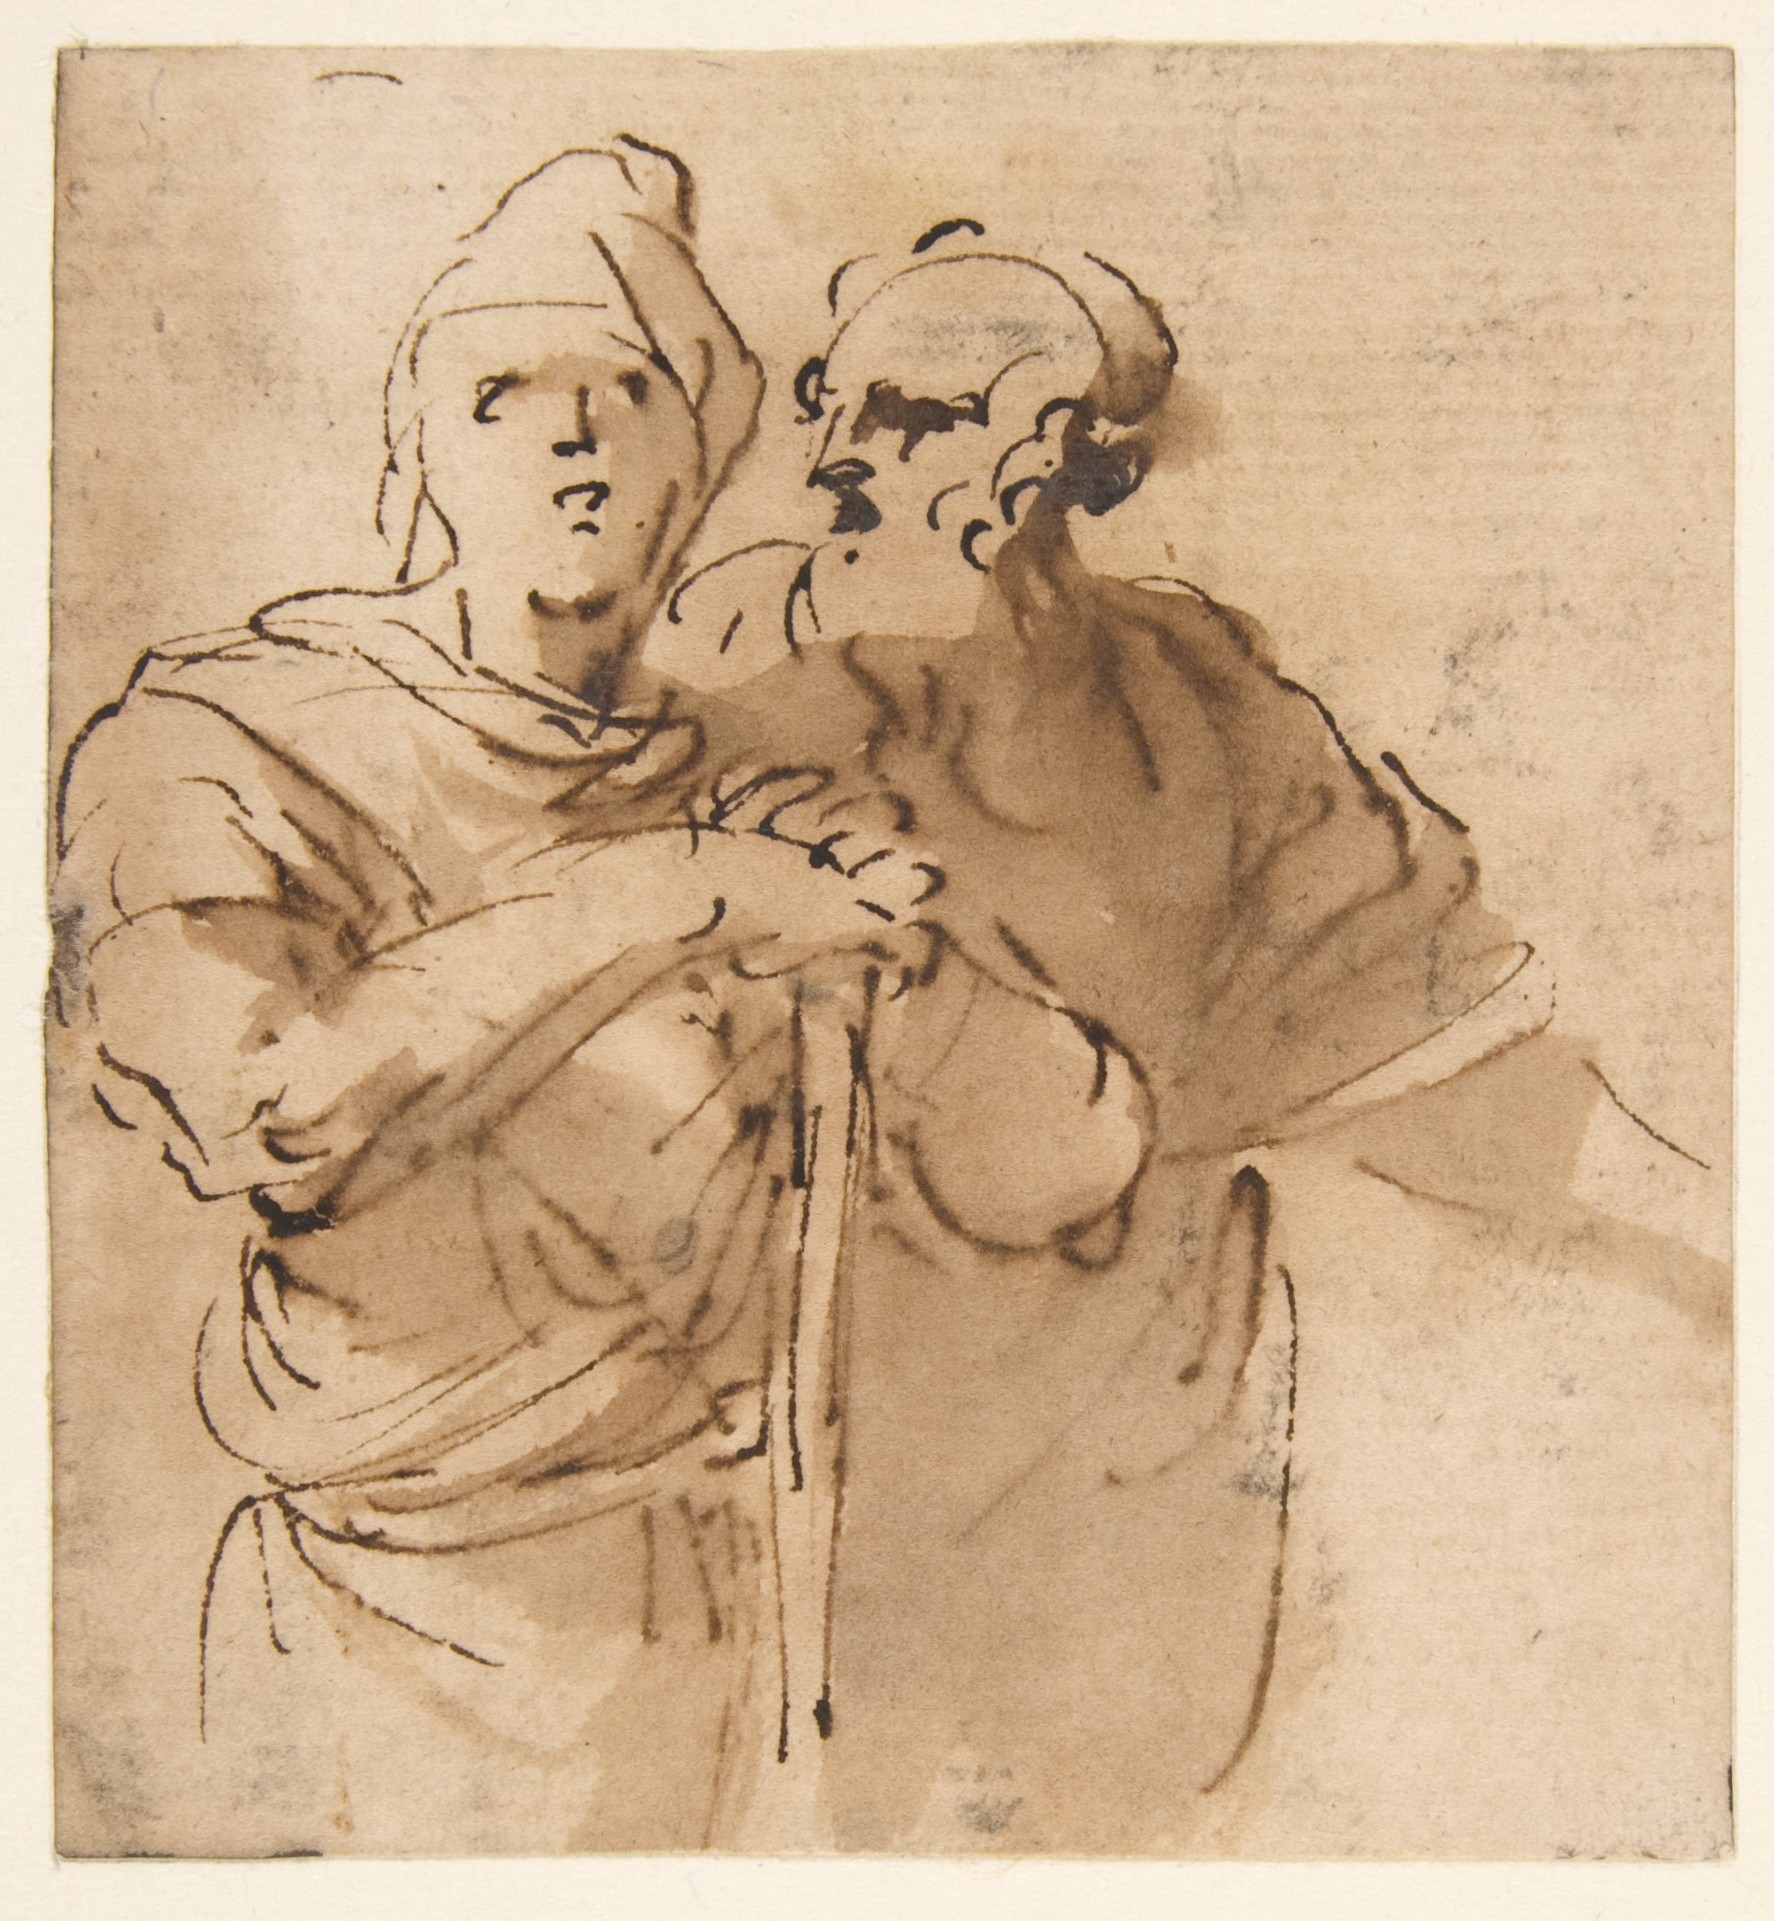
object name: drawing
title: Two Men Seen Three- Quarter Length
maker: salvator rosa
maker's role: artist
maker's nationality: italian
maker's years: 1615-1673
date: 1615-1673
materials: ink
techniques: pen, wash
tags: men